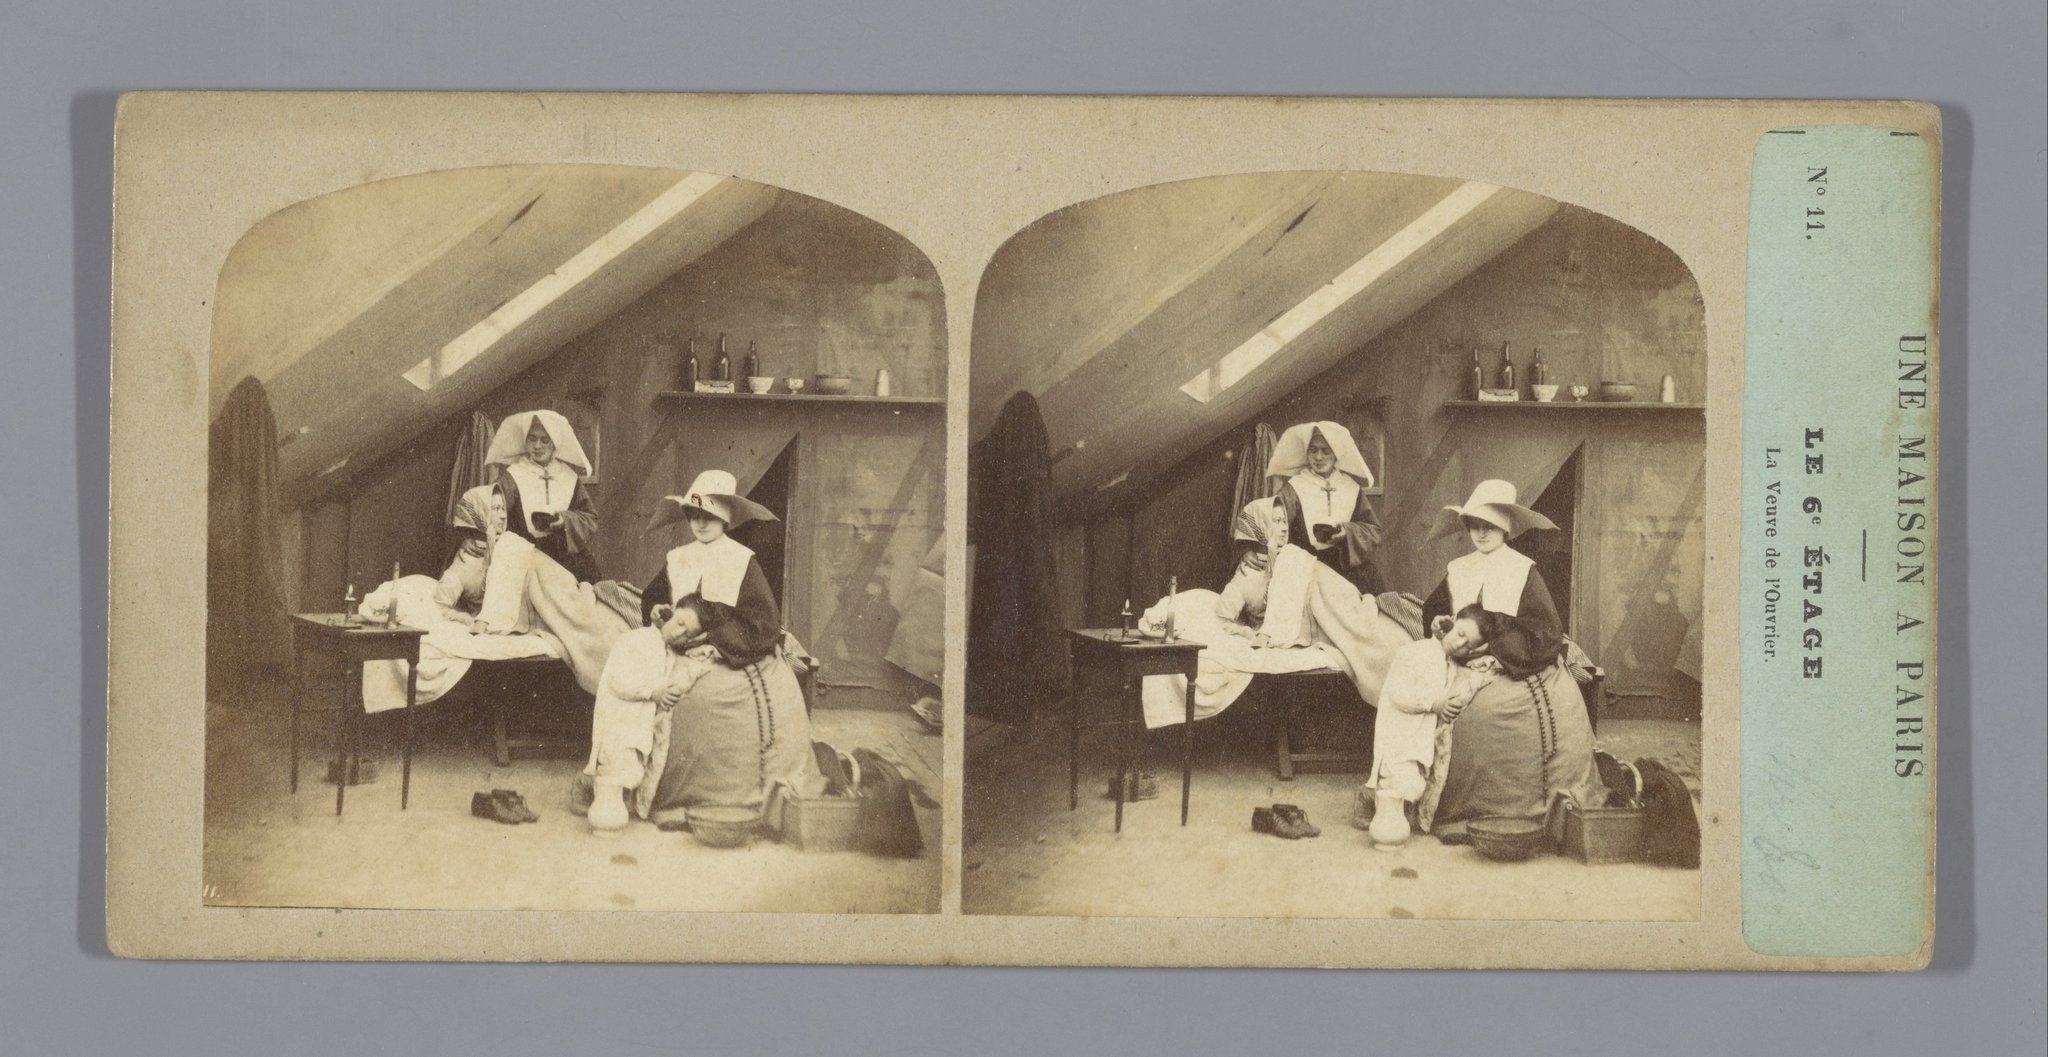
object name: stereograph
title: Theatrale voorstelling van een vrouw in bed met daarnaast twee nonnen en een jongen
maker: Anonymous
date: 1850-1880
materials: cardboard, photographic support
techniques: albumen print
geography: france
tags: sick-bed, nun(s), europe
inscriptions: inscription: ‘JB’, number: ‘No 11.’